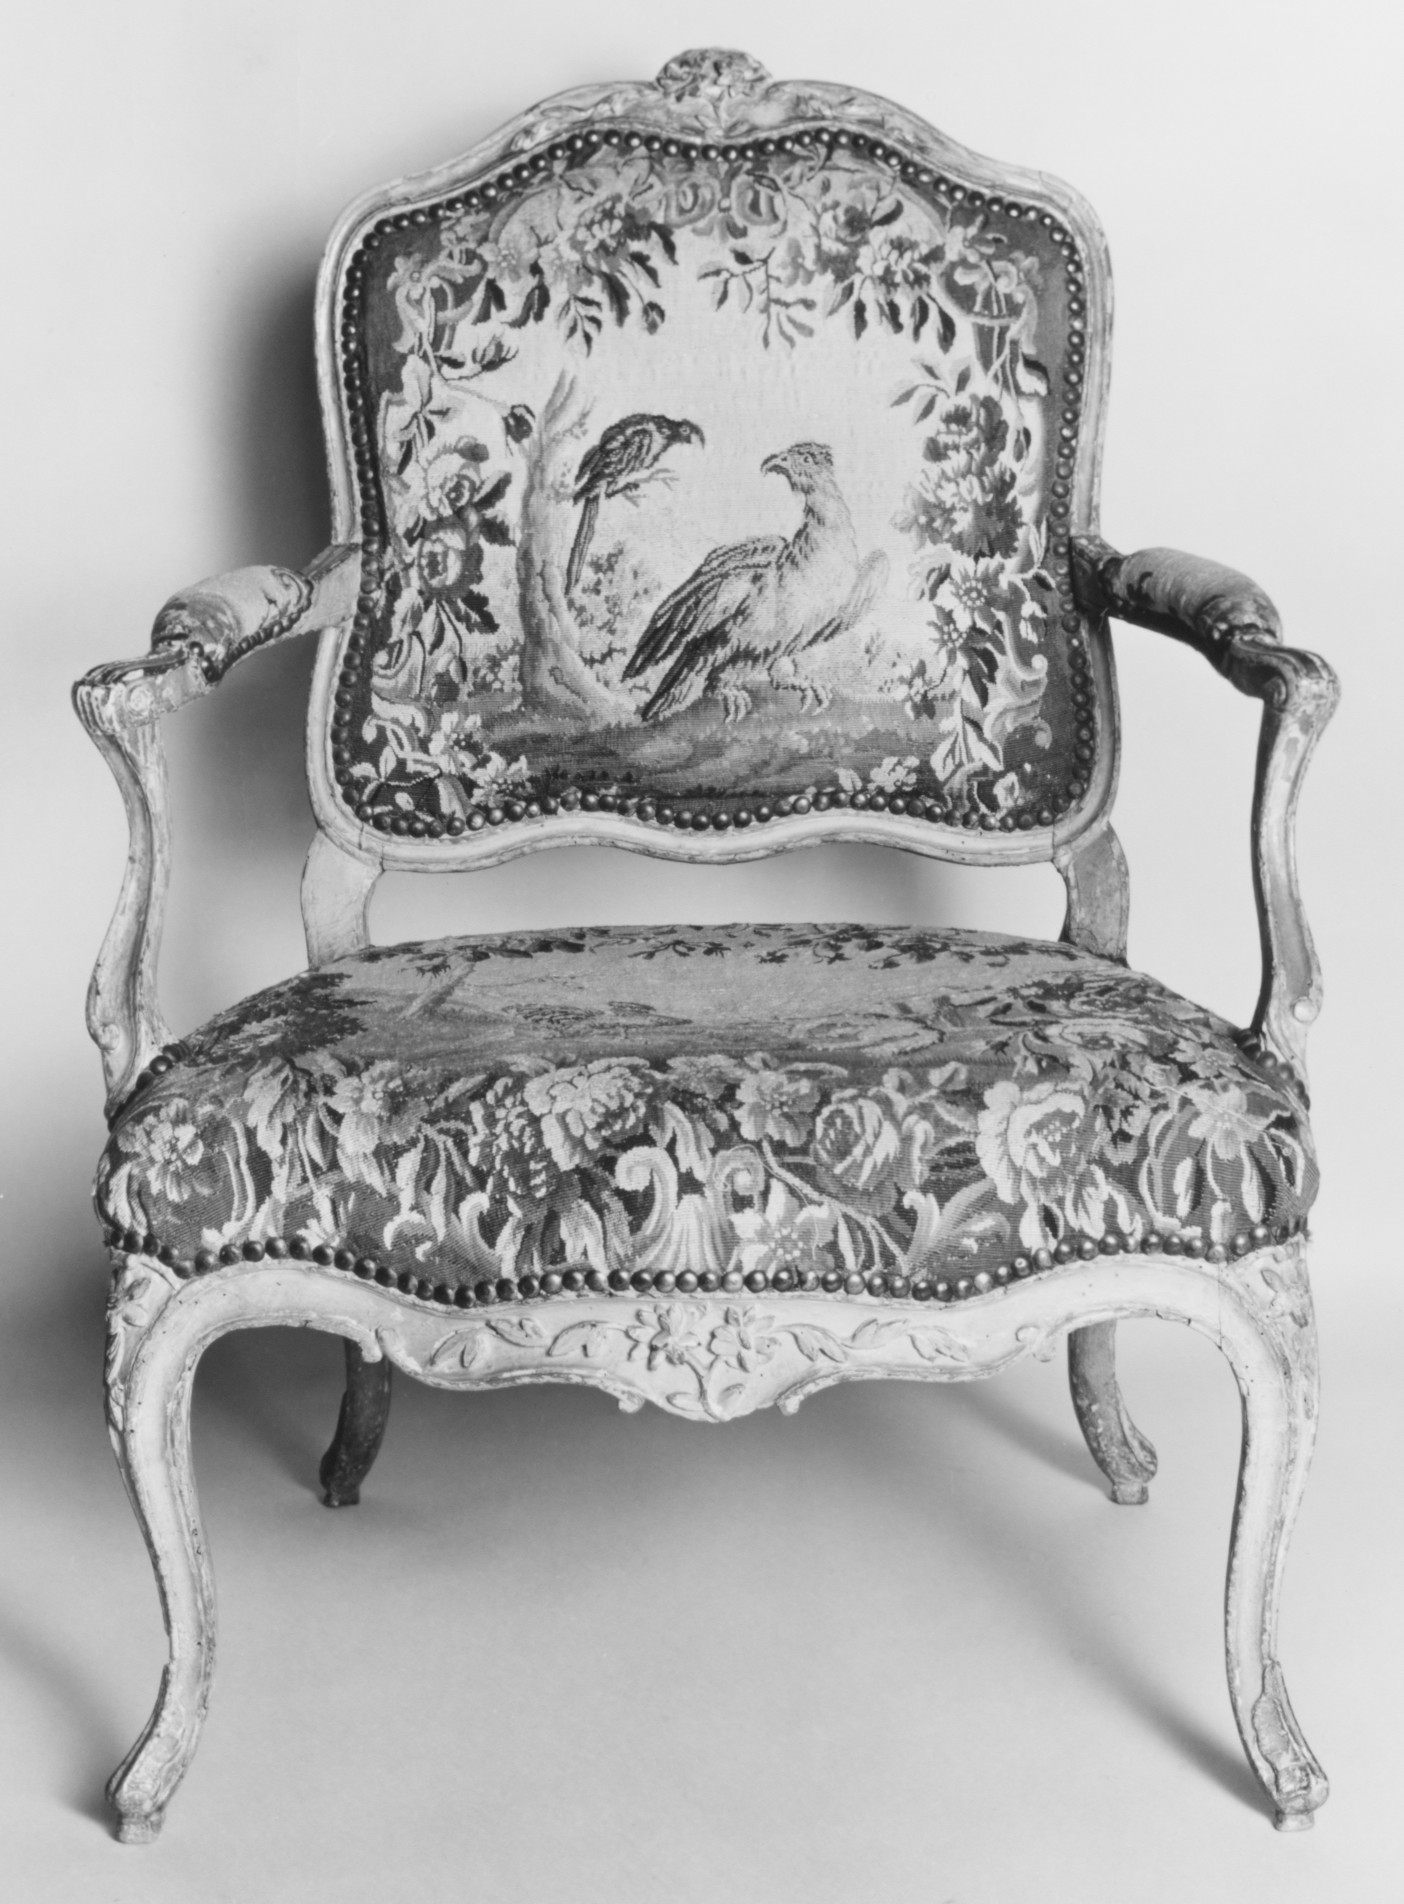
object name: armchair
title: Armchair (part of a set of nine)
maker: aubusson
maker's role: factory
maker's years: 1665-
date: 1734-1766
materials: wood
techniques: carving, painting, tapestry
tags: birds,flowers